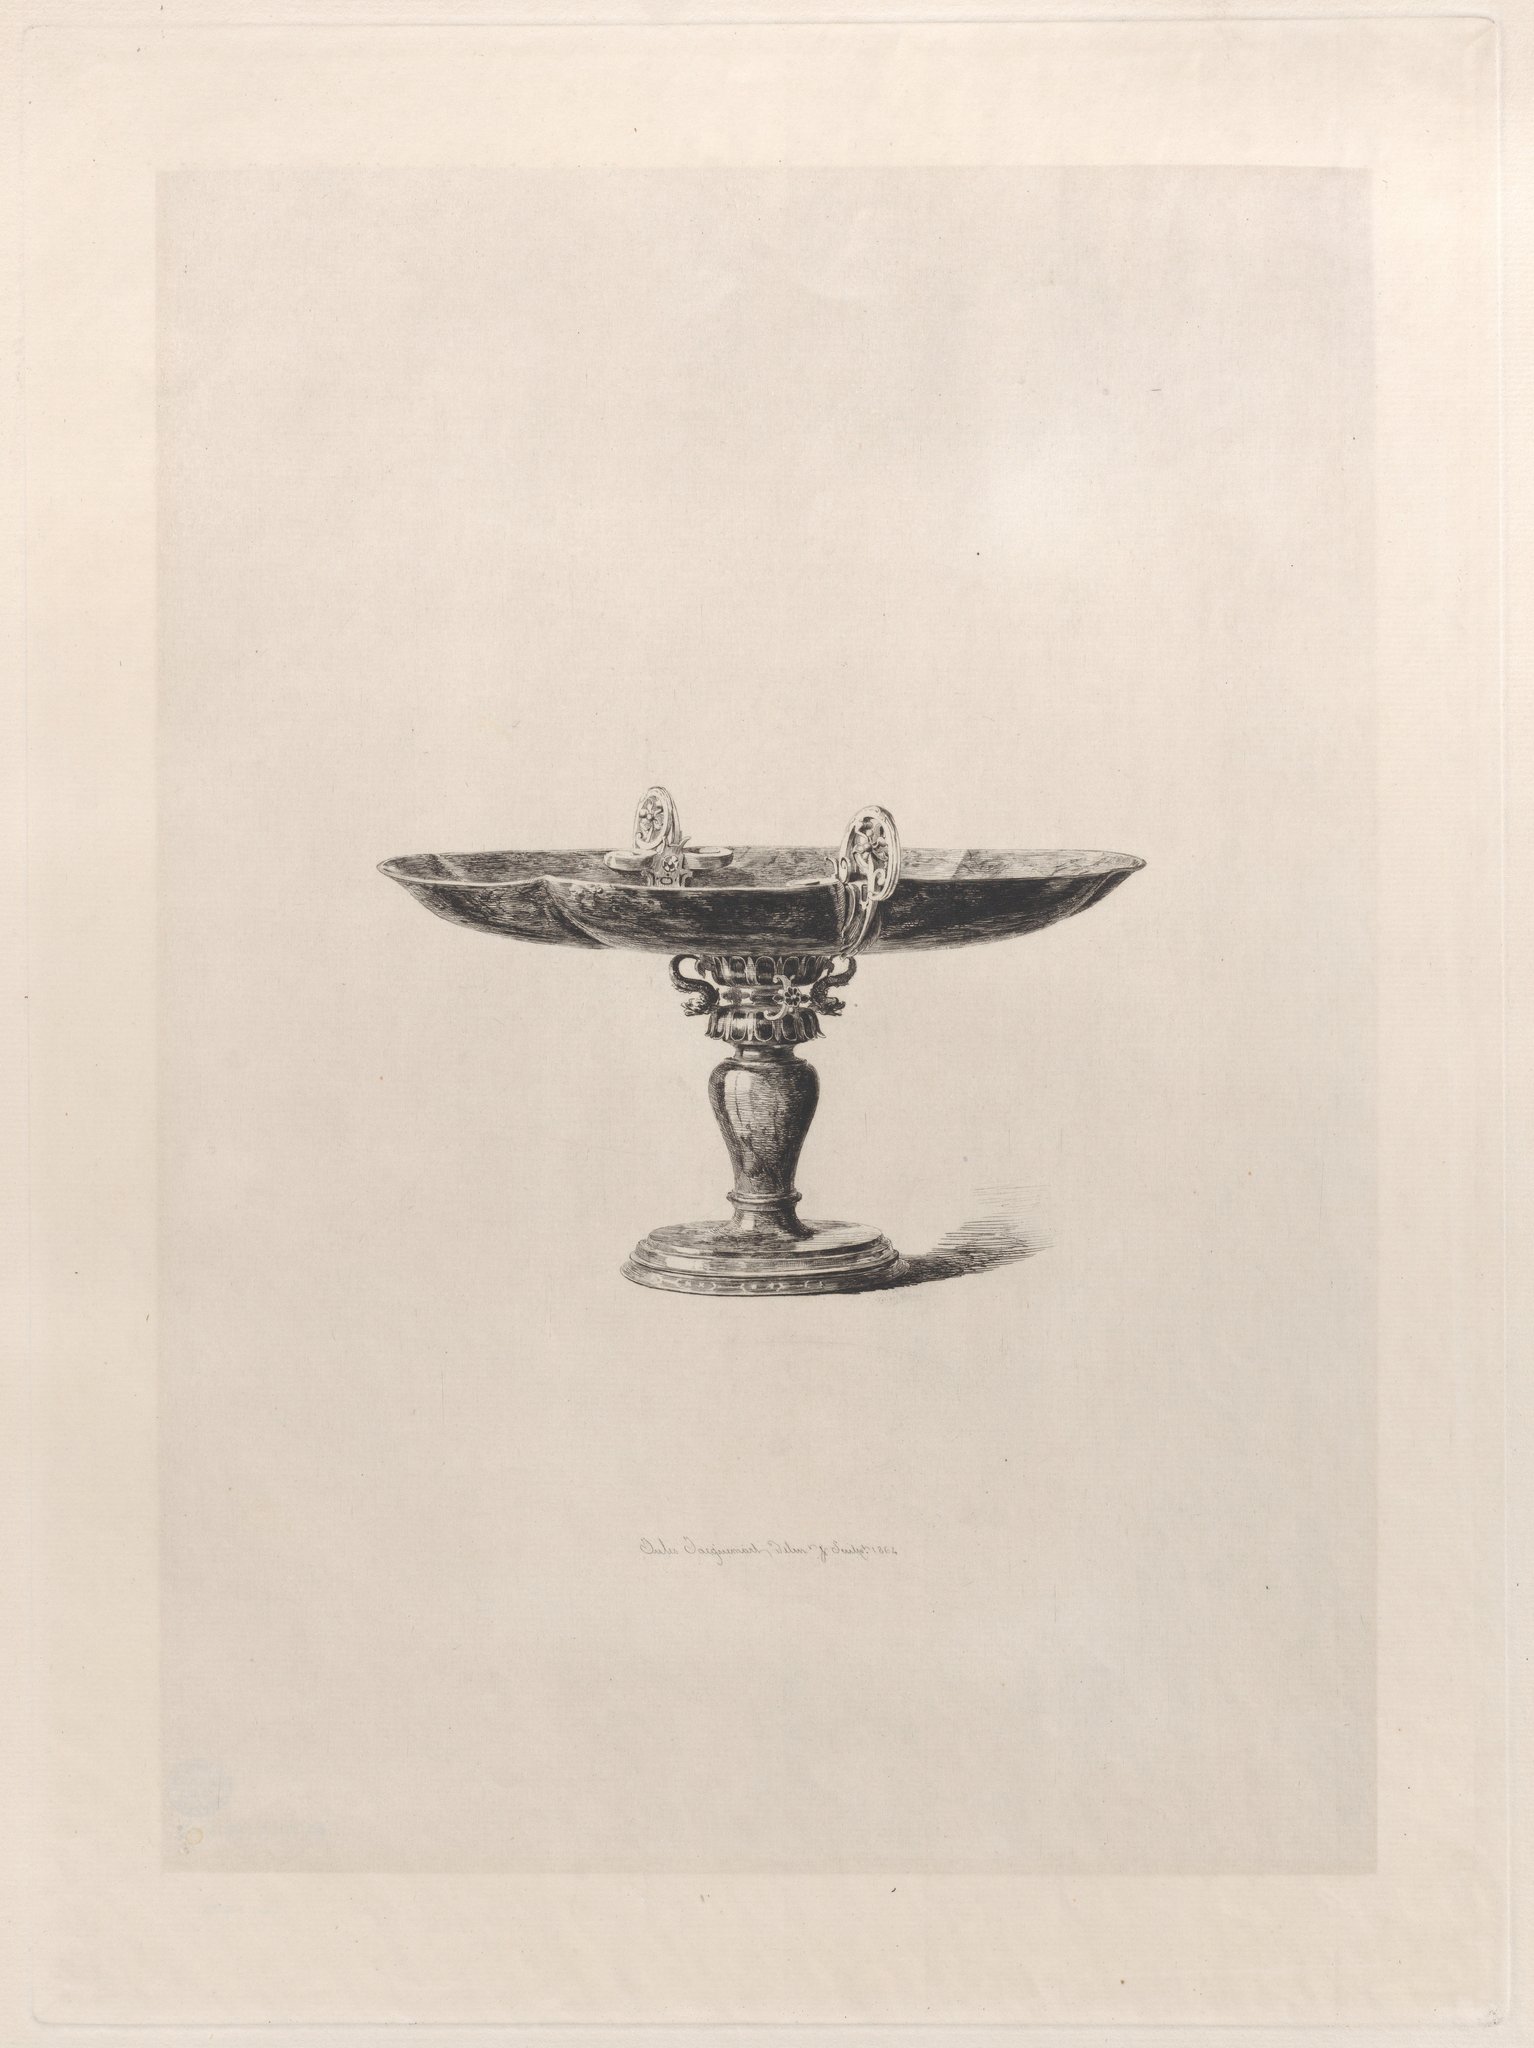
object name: print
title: Oriental Jasper Cup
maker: jules-ferdinand jacquemart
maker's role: artist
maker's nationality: french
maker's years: 1837-1880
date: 1864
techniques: etching